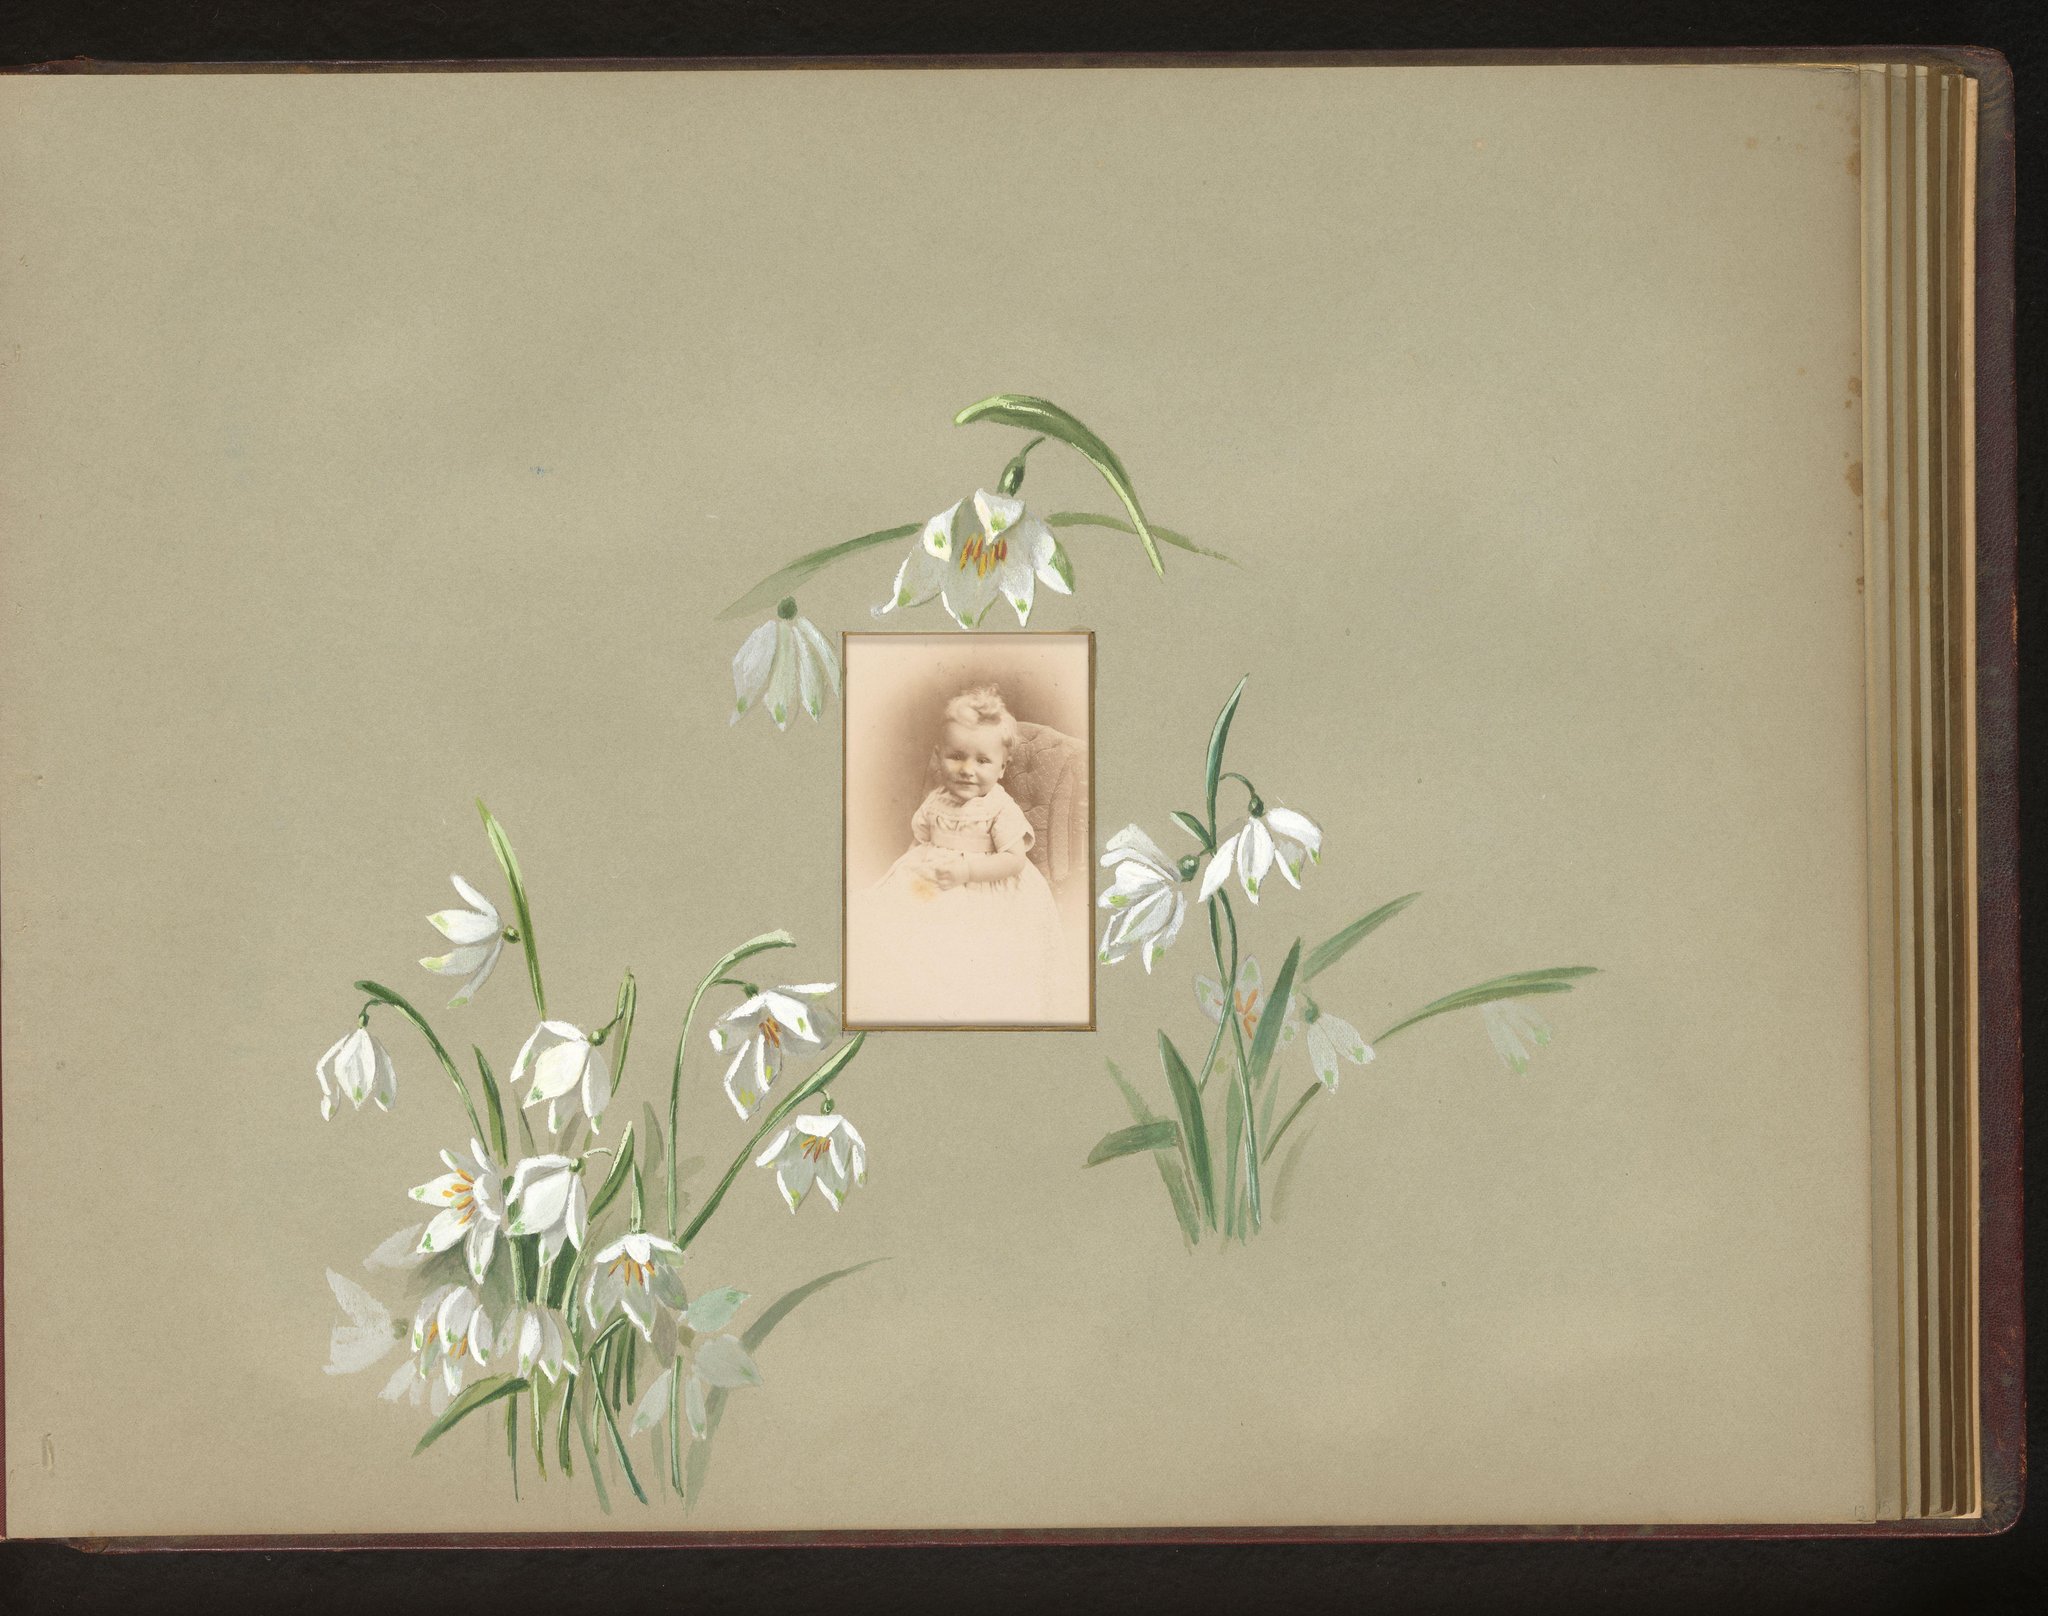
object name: photograph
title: Portret van een kind uit de familie Zeller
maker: Anonymous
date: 1872-1897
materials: paint, photographic support, watercolor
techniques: albumen print, brush, hand coloring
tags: toddler